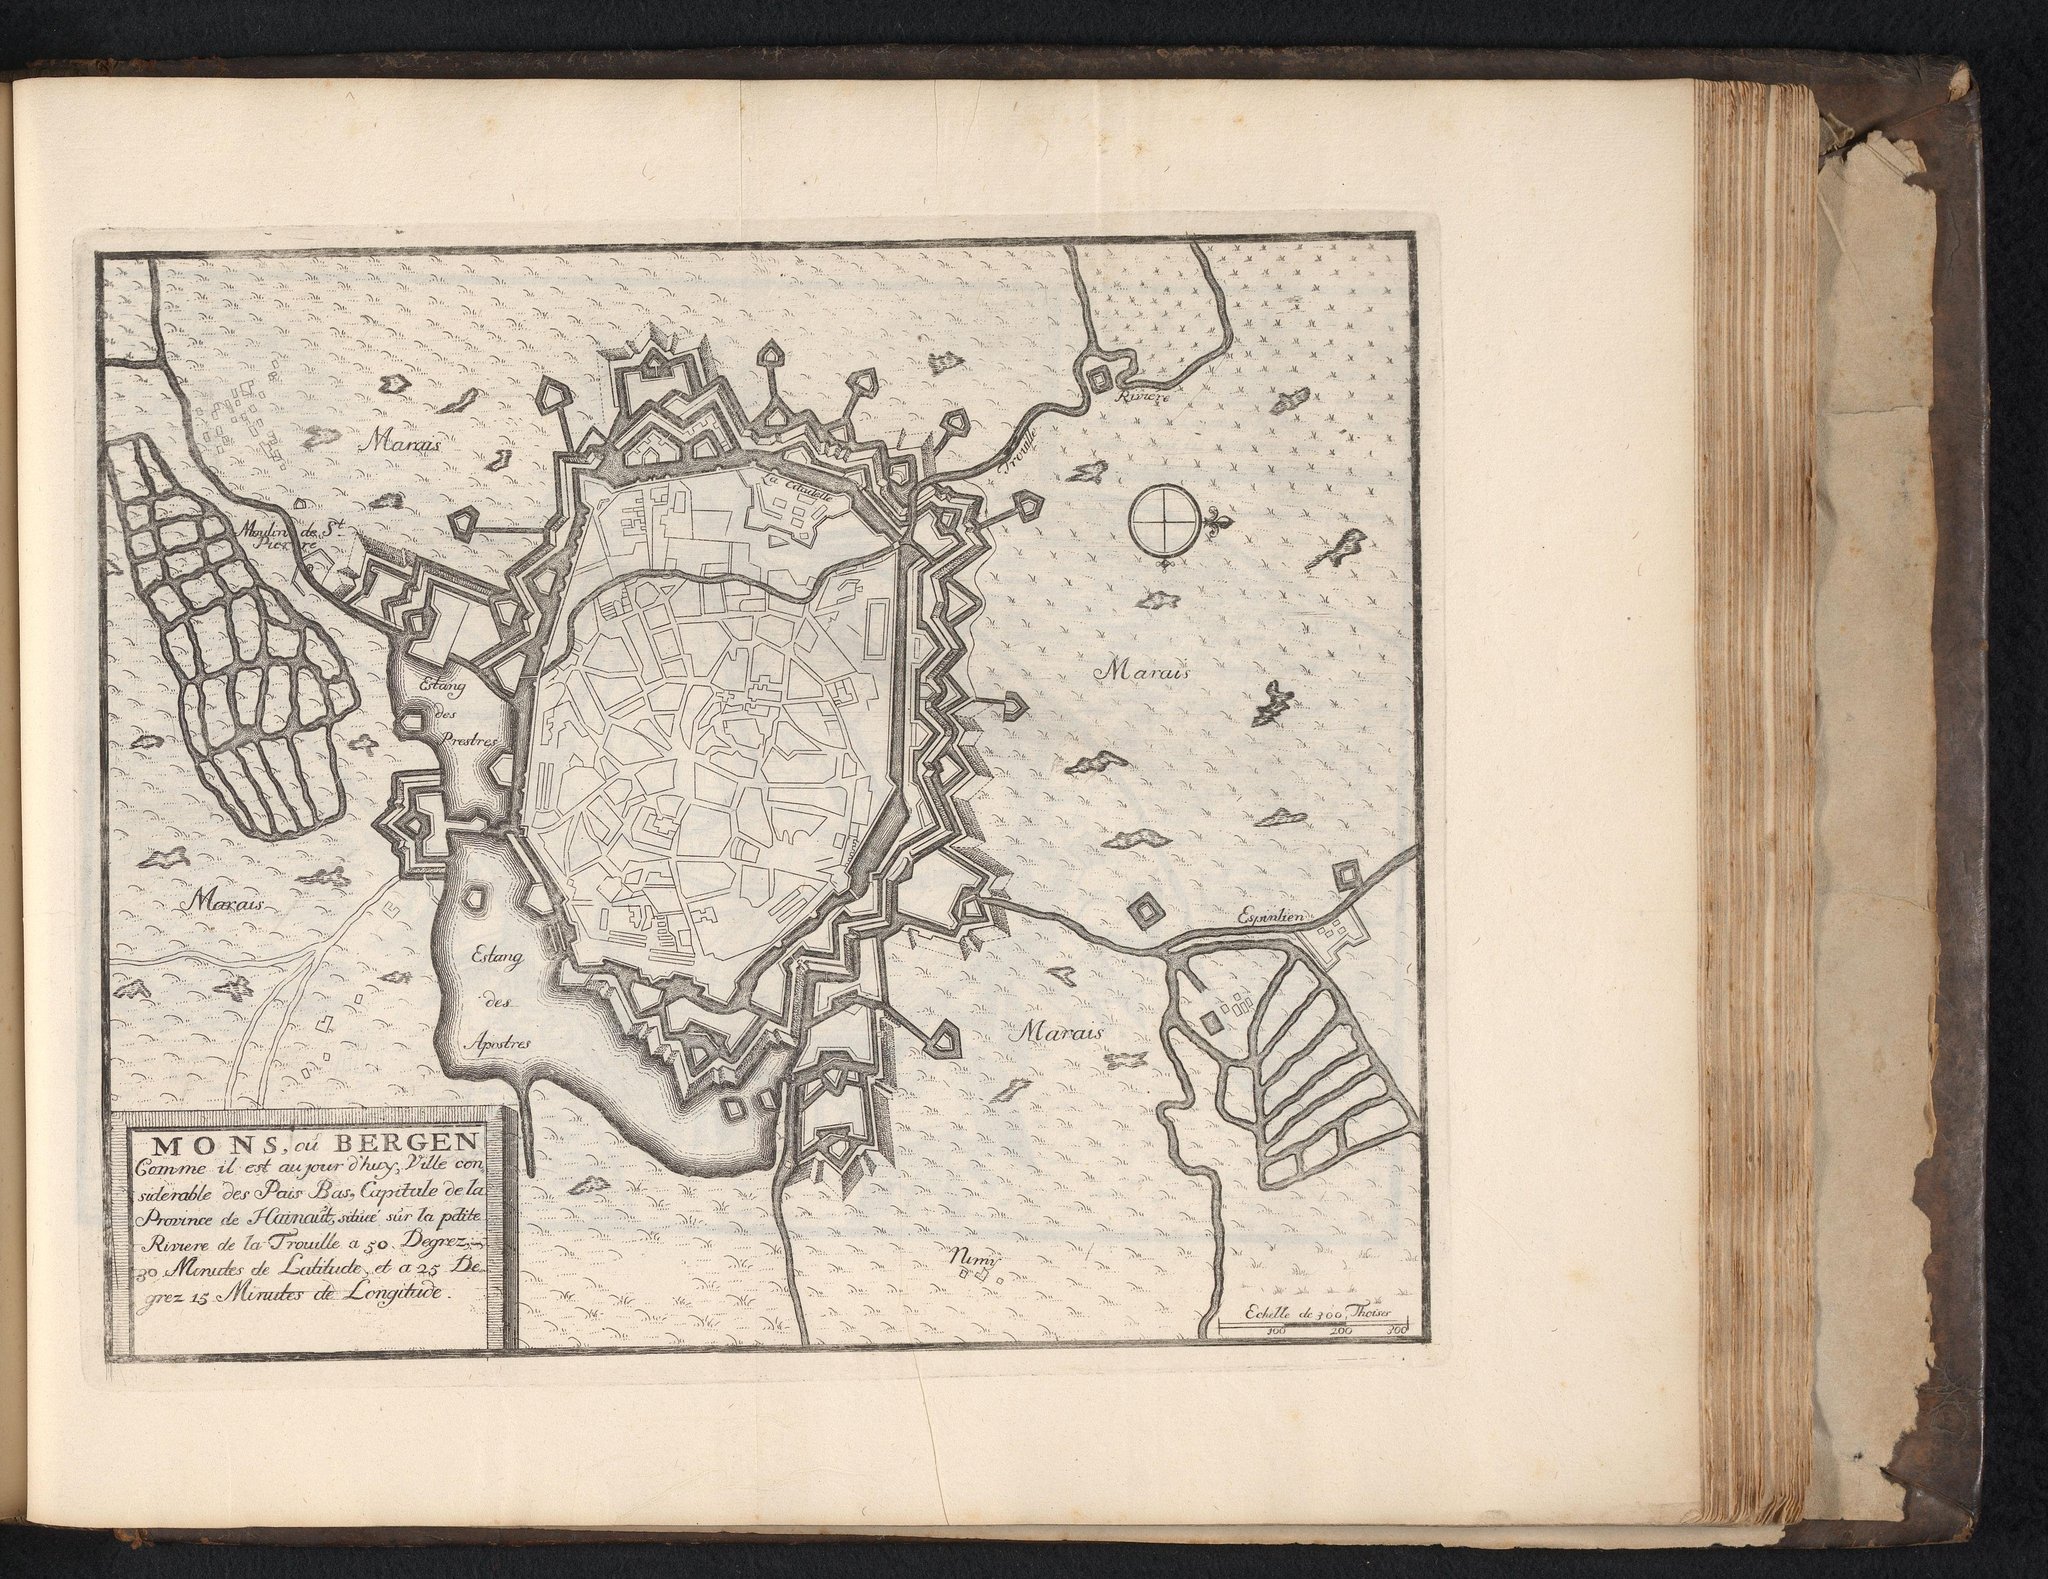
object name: print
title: Plattegrond van Mons, ca. 1693-1696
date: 1693-1696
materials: paper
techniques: etching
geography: france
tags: fortress, maps of cities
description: Plattegrond van de versterkingen van de stad Mons (Bergen) in de graafschap Henegouwen. Onderdeel van het eerste van twee delen van het prentwerk: Le Theatre de la Guerre, dans les Pays-Bas, waarvan het titelblad uitgegeven is in 1696. Het prentwerk bestaat in totaal (beide delen) uit 52 platen met plannen (afkomstig van Sébastien Le Prestre, Seigneur de Vauban) van vermaarde sterke steden en vestingen in de Negenjarige Oorlog in de Nederlanden. Variant (kopie?) van de plaat die voorkomt in: Les forces de l'Europe, uitgegeven tussen 1693-1697. Titel en opschriften in het Frans.